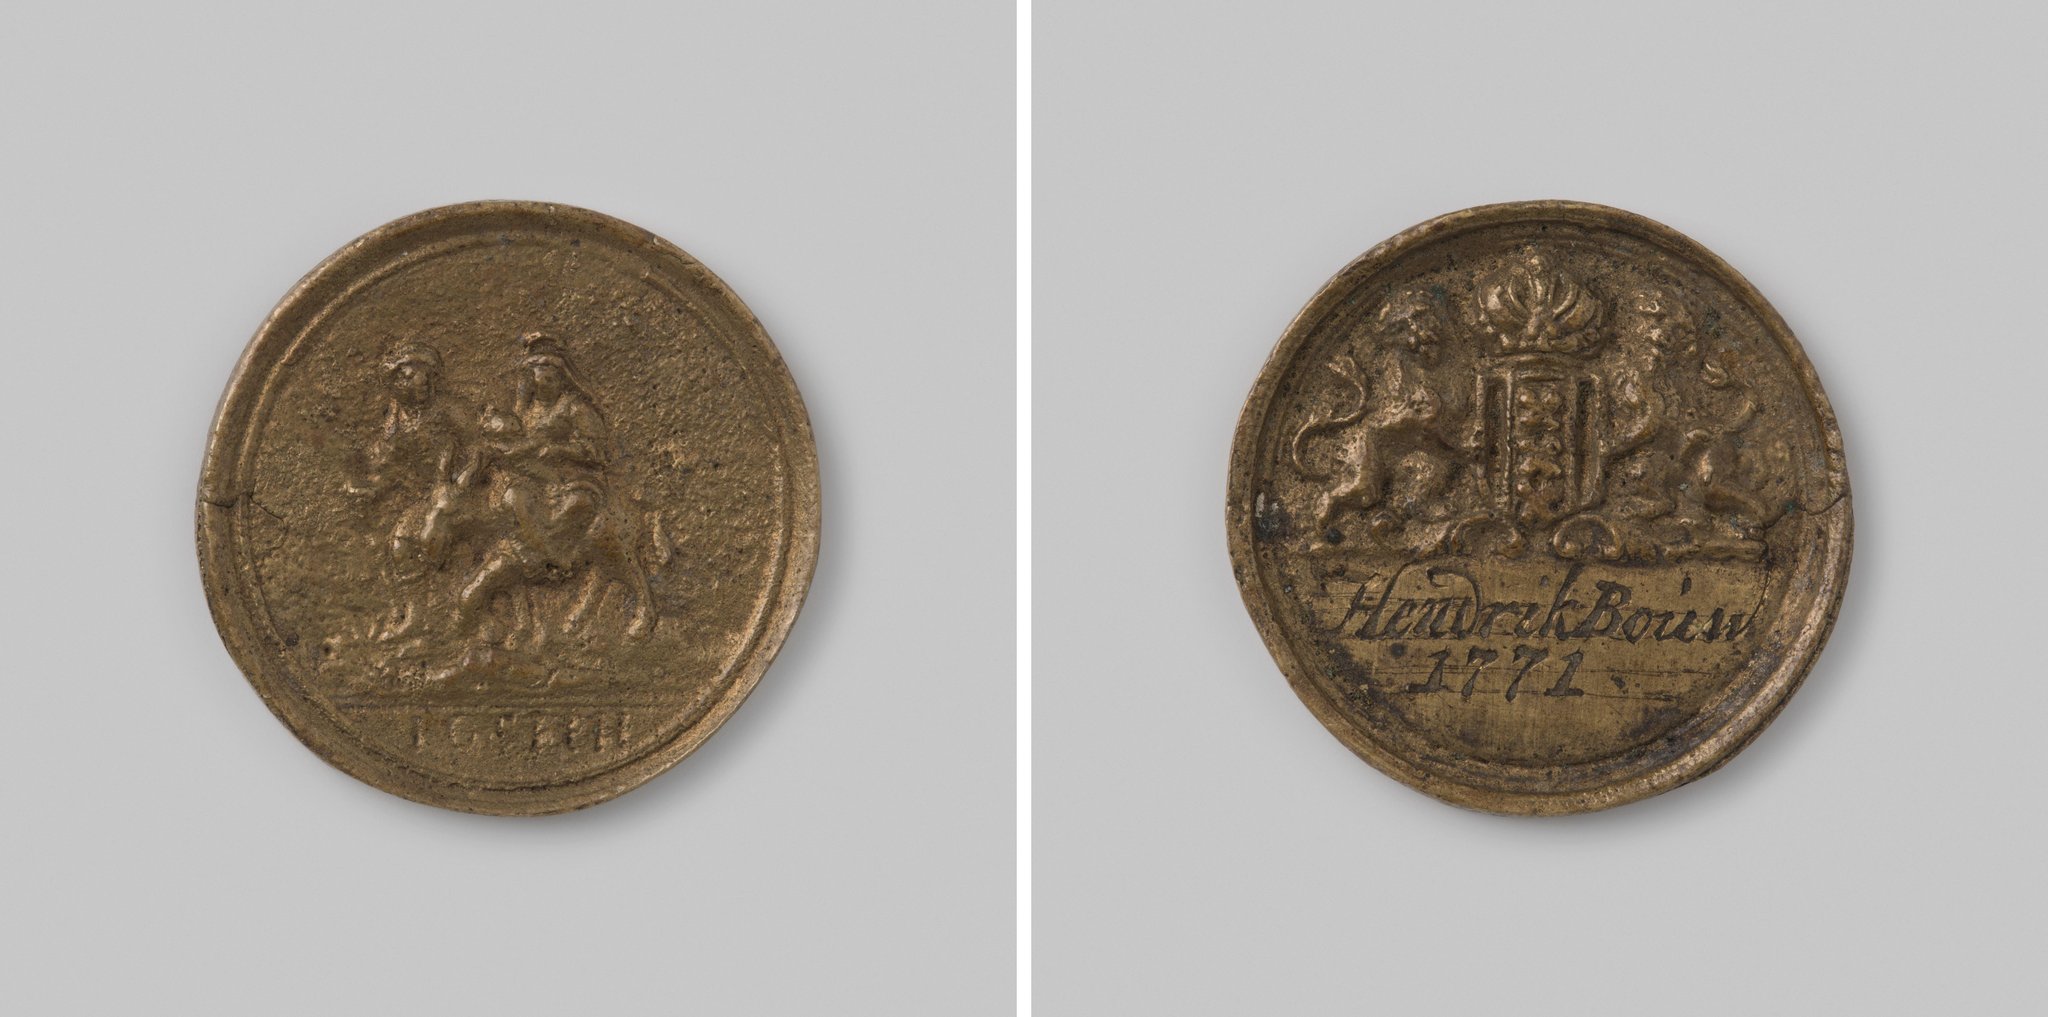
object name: medal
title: Presentiepenning van het Sint Joseph- of Timmerliedengilde te Amsterdam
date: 1771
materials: brass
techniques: casting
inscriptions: inscription: ‘Hendrik Bouw / 1771’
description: Gegoten messing penning met op de voorzijde Jozef met stok en Maria met Jezus op ezel, in de afsnede IOSEPH, op de keerzijde boven het gekroonde wapenschild van Amsterdam met dragers en onder een inscriptieruimte, op naam van Hendrik Bouw 1771